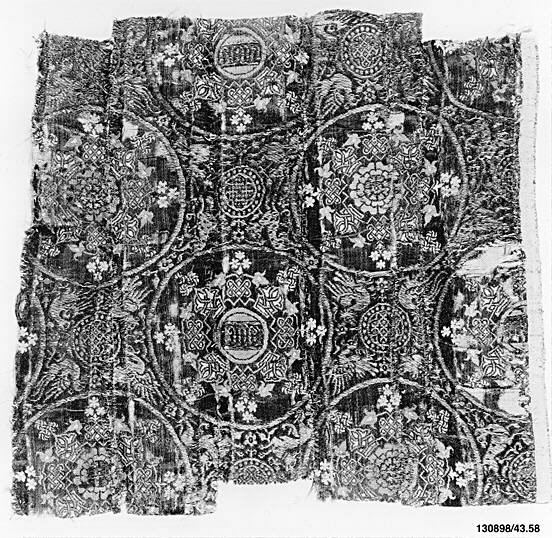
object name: joined fragment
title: Joined Fragments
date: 1301-1400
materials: metal thread, silk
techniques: brocade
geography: central asia or eastern iran